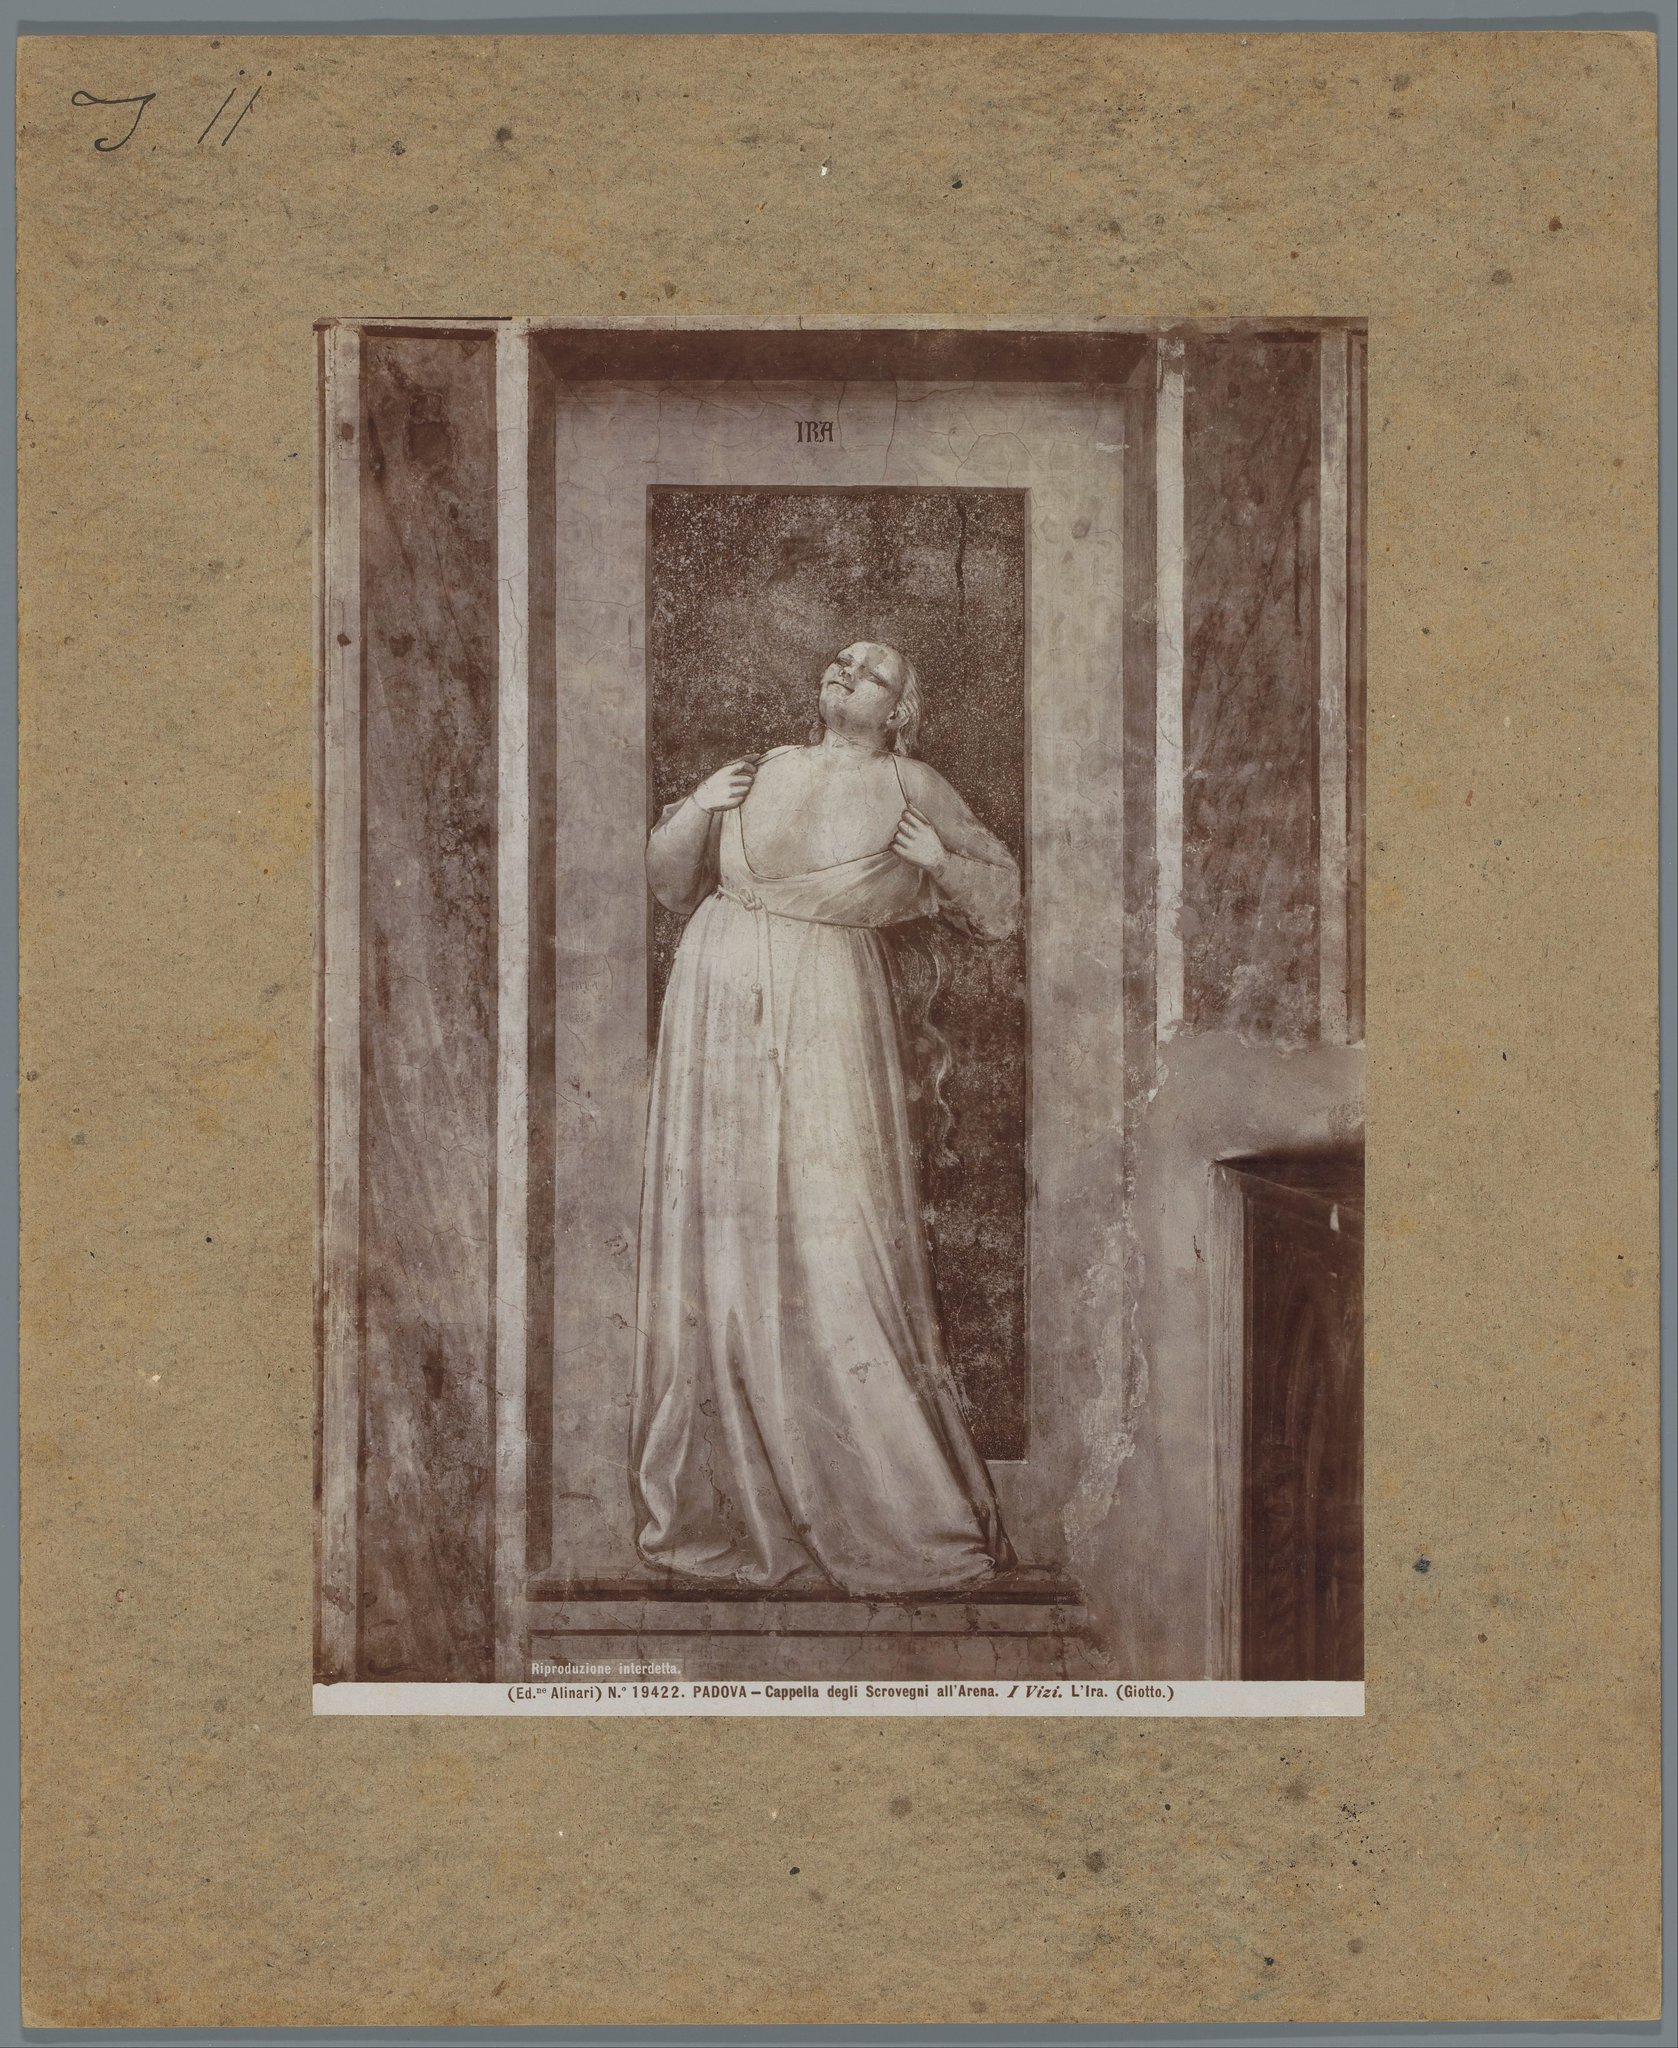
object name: reproduction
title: PADOVA - Cappella degli Scrovegni all'Arena. I Vizi. L'Ira.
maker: giotto de bondone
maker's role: painter, sculptor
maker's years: 1266-1337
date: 1875-1900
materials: cardboard, photographic support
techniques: albumen print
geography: scrovegnikapel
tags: anger; 'ira' (ripa) ~ personification of one of the seven deadly sins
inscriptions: number: ‘No. 19422.’, collector's mark: Lugt 3937